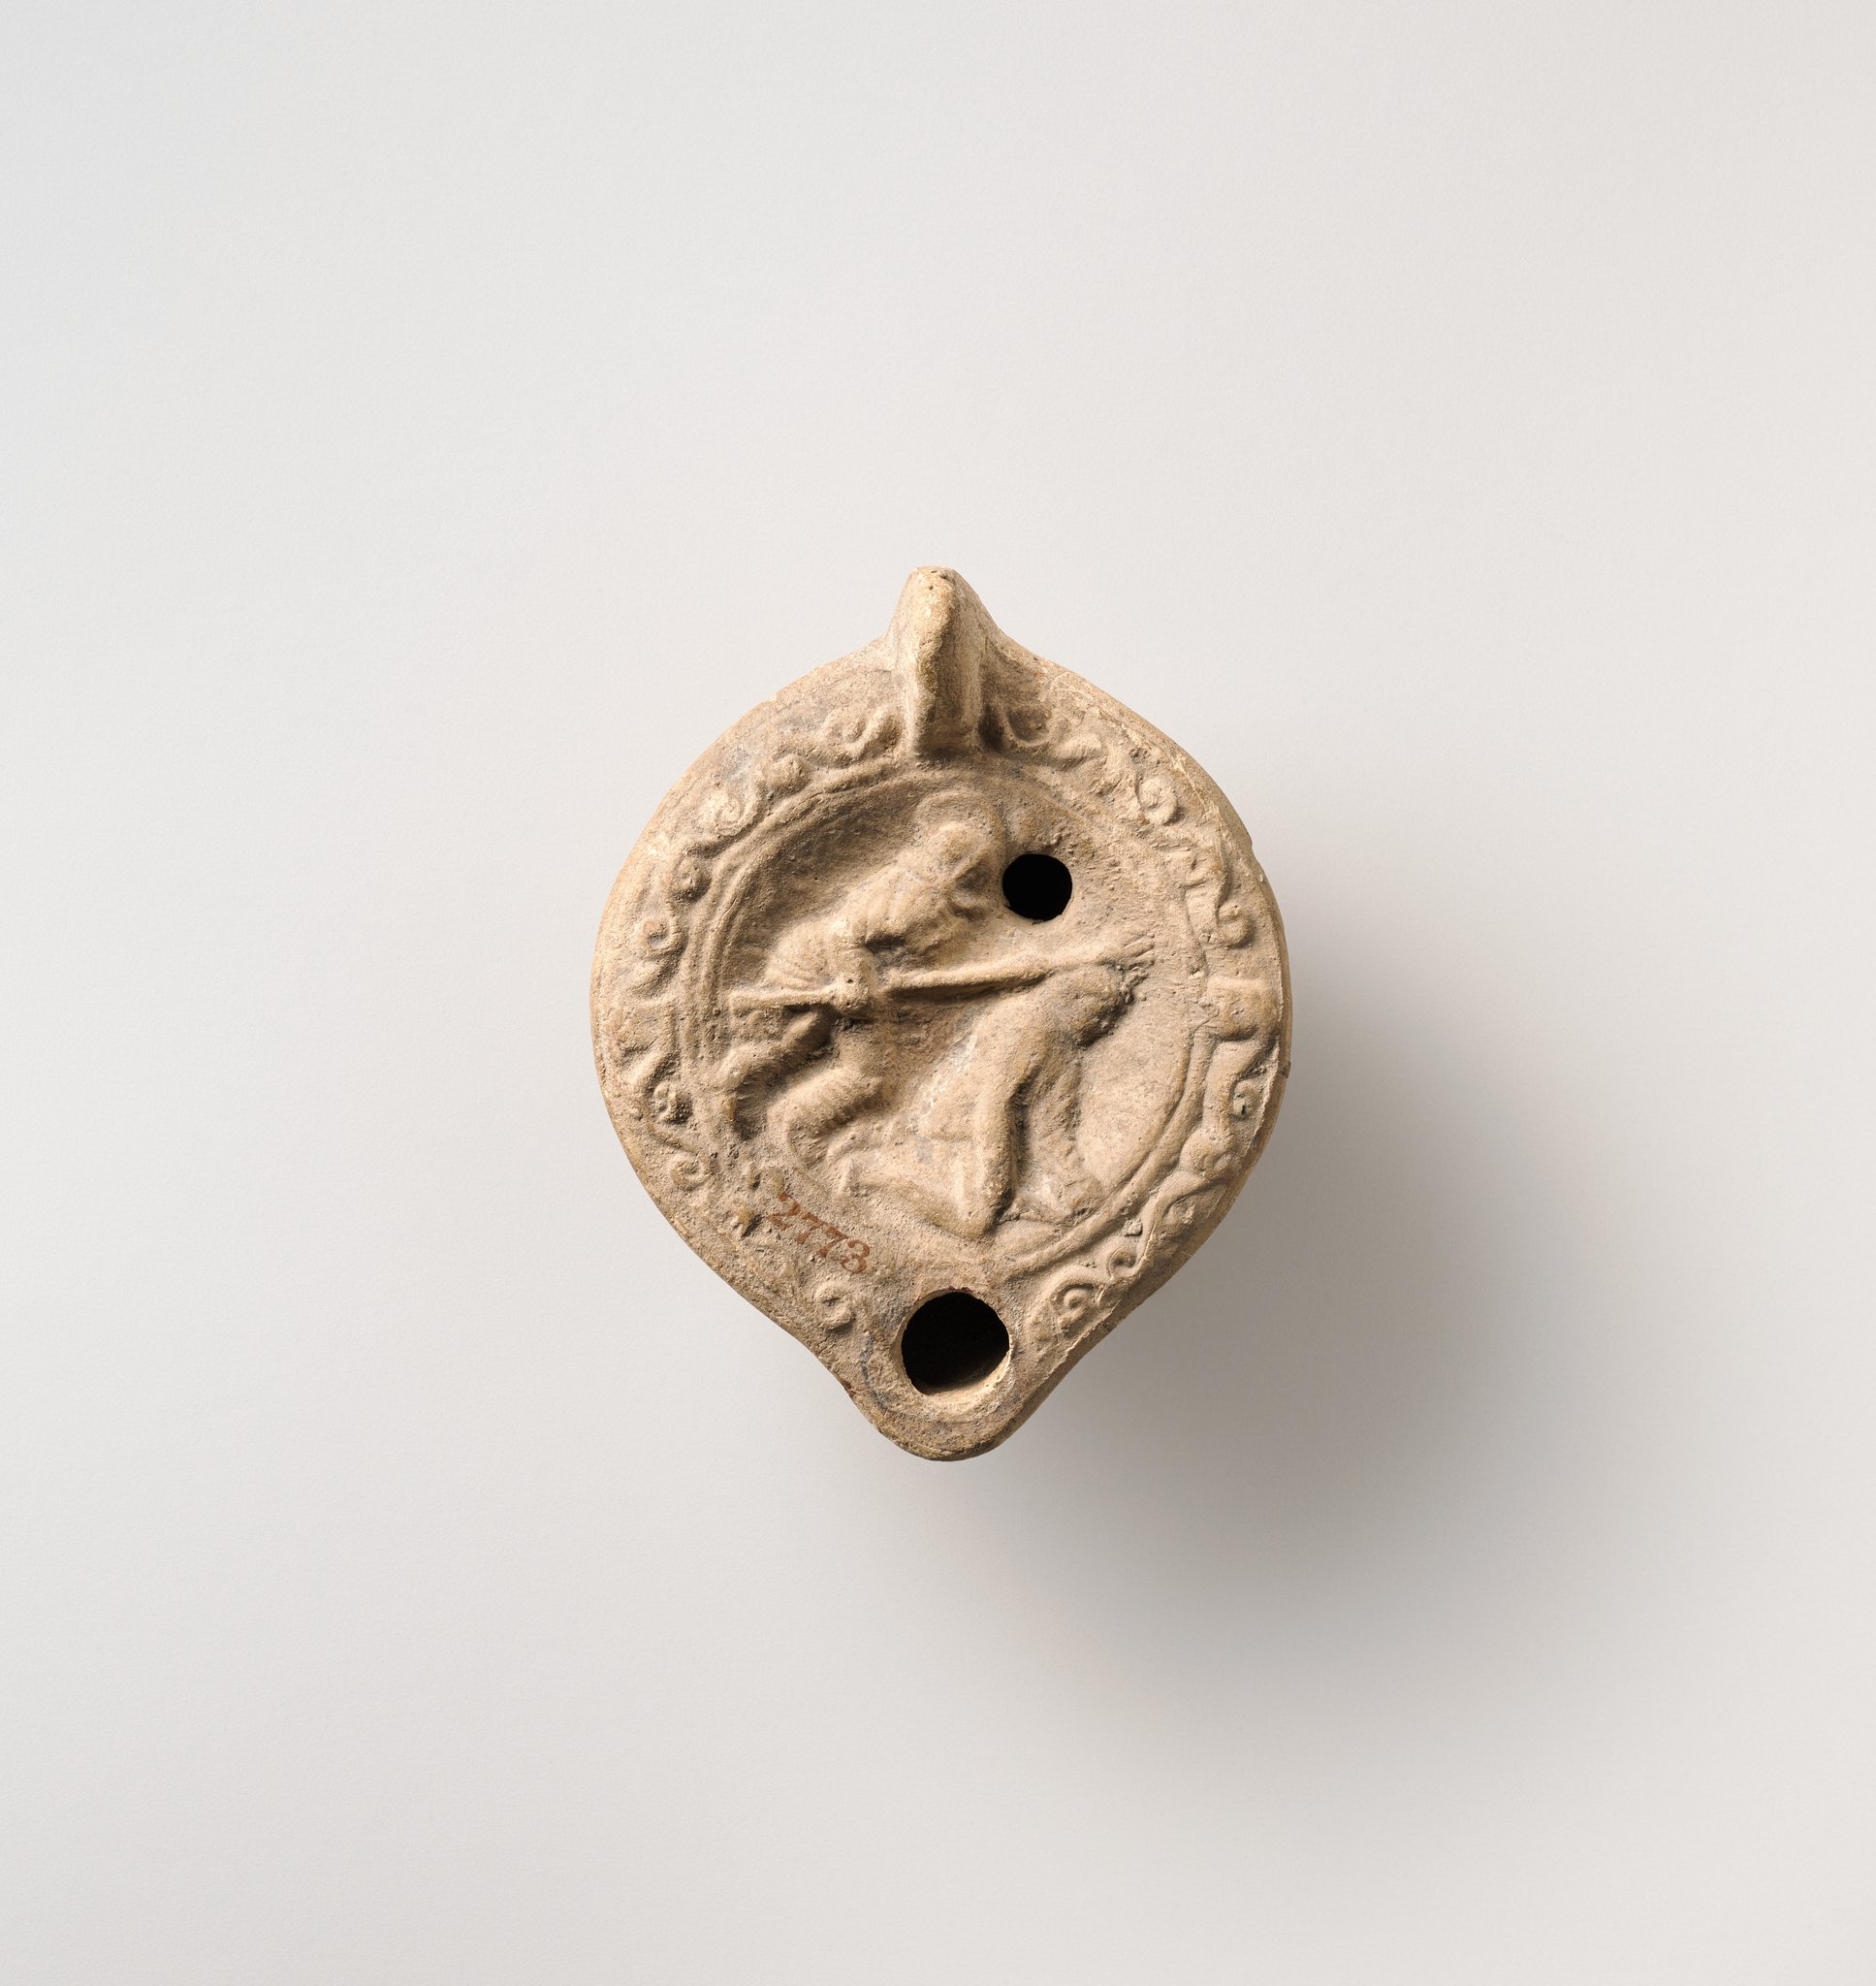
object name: lamp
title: Terracotta oil lamp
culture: roman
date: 201-300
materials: terracotta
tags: men,gladiators